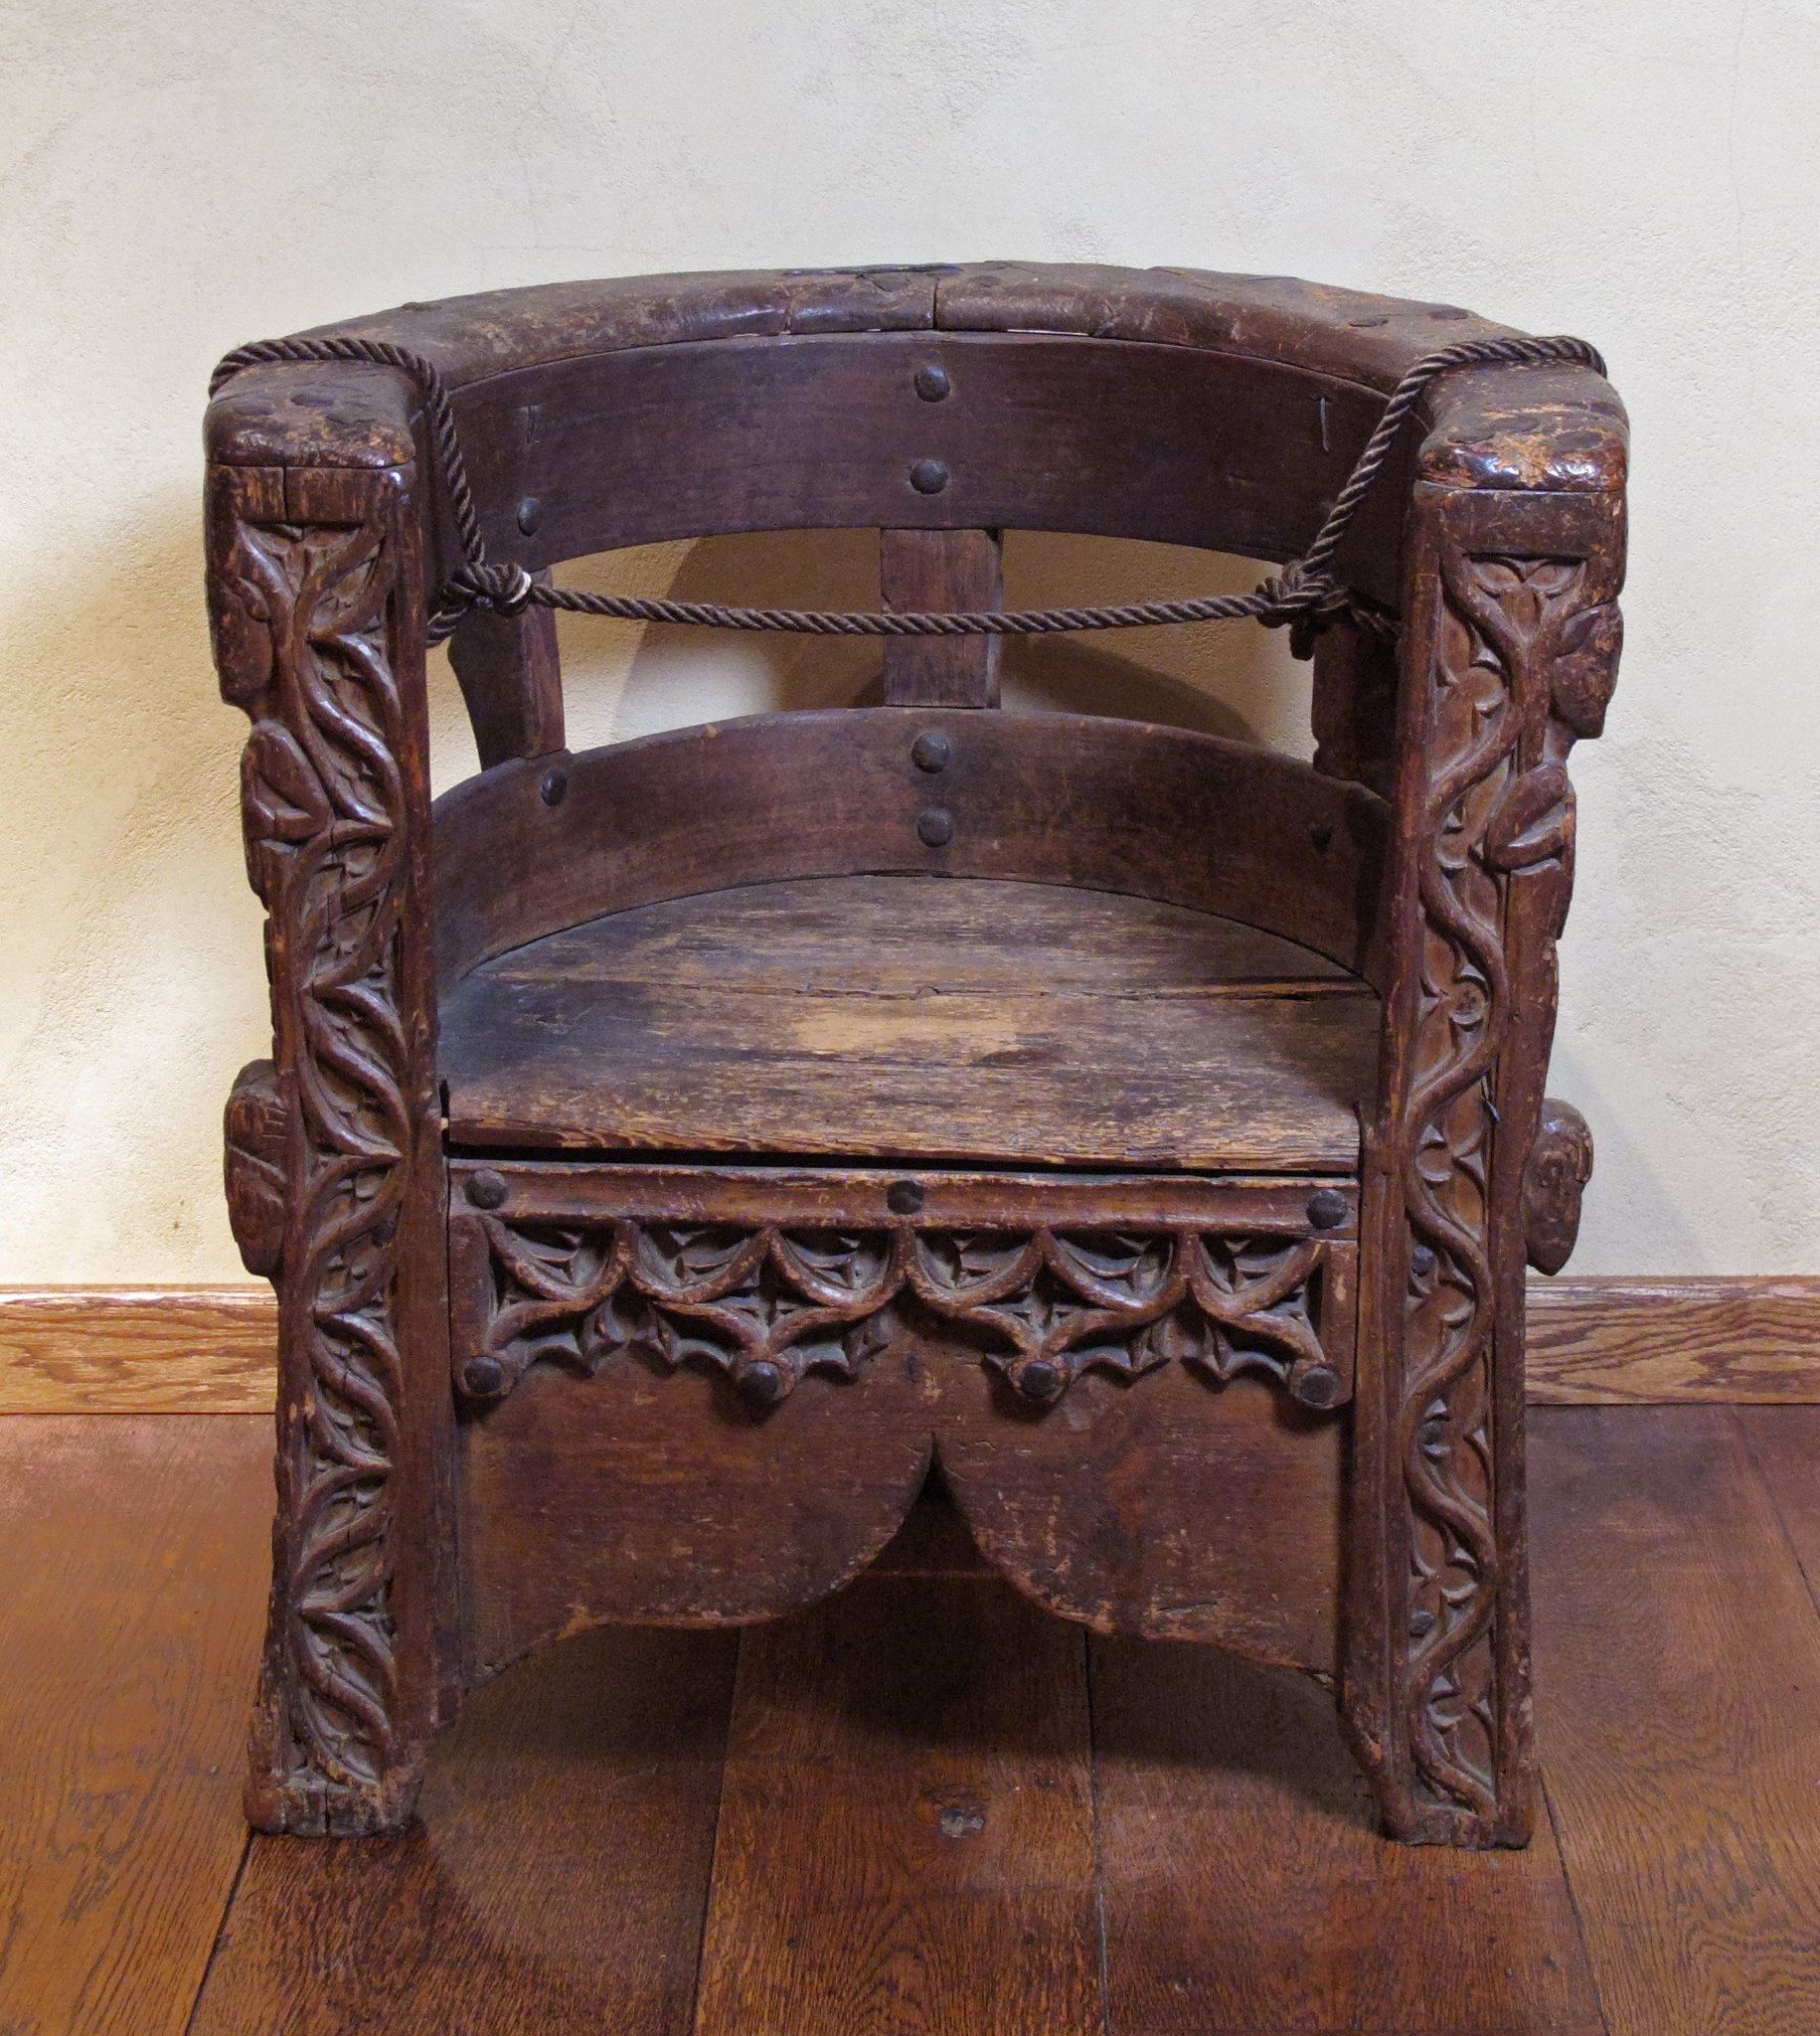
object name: chair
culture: italian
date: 1401-1500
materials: wood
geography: italy